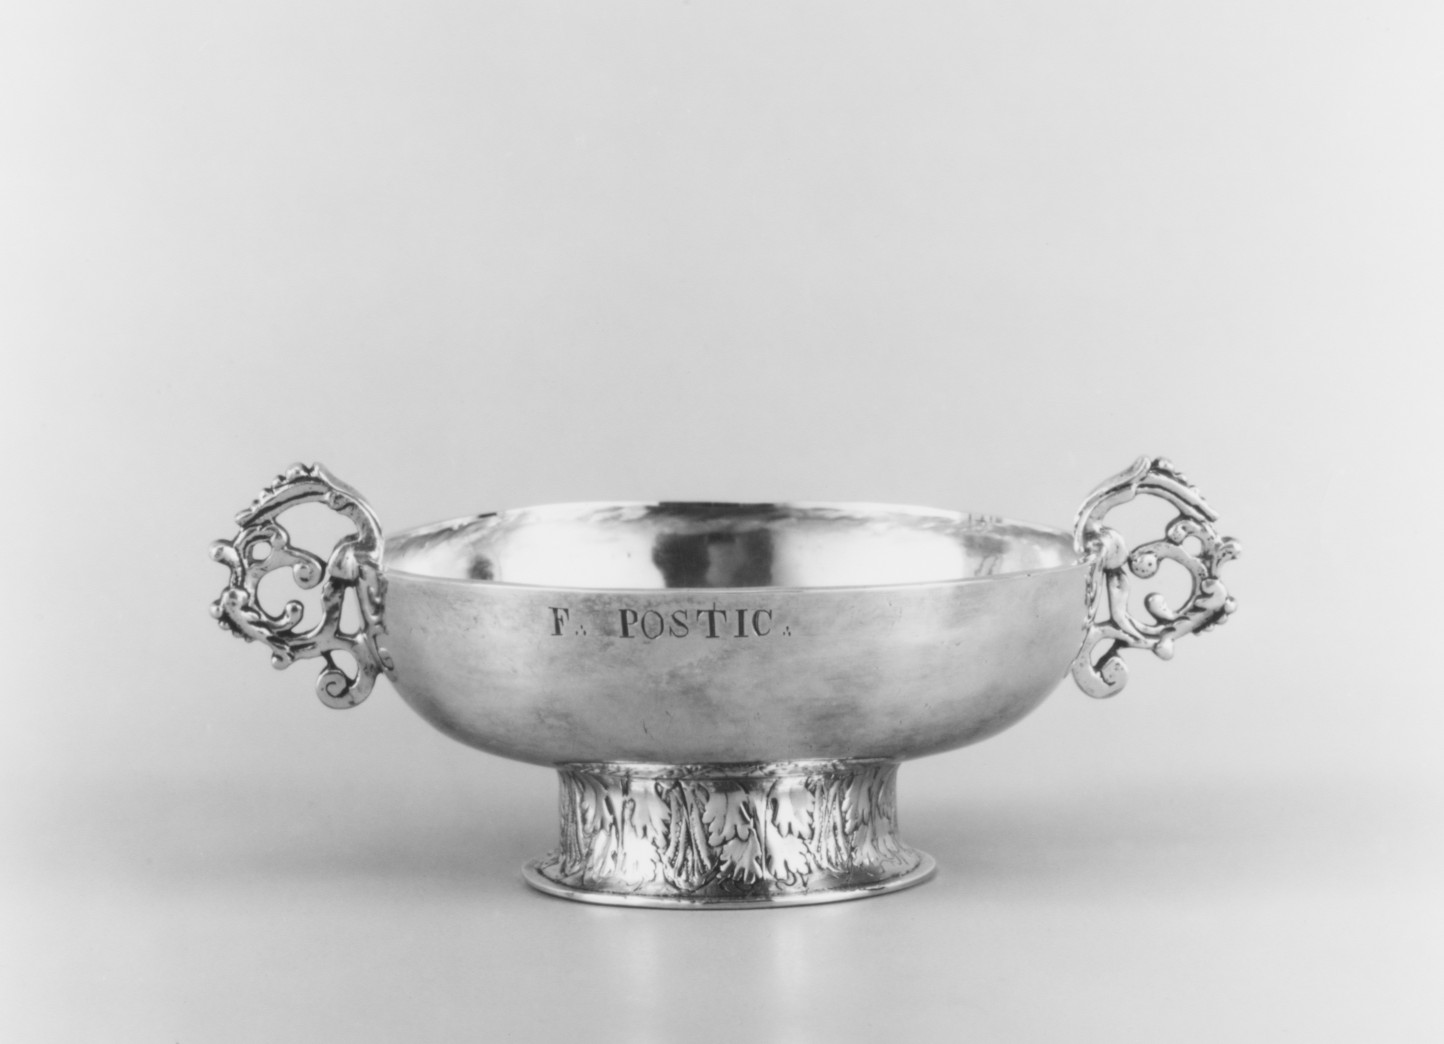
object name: collection cup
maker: joseph lucas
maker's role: maker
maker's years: 1639-1739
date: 1725-1730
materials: silver